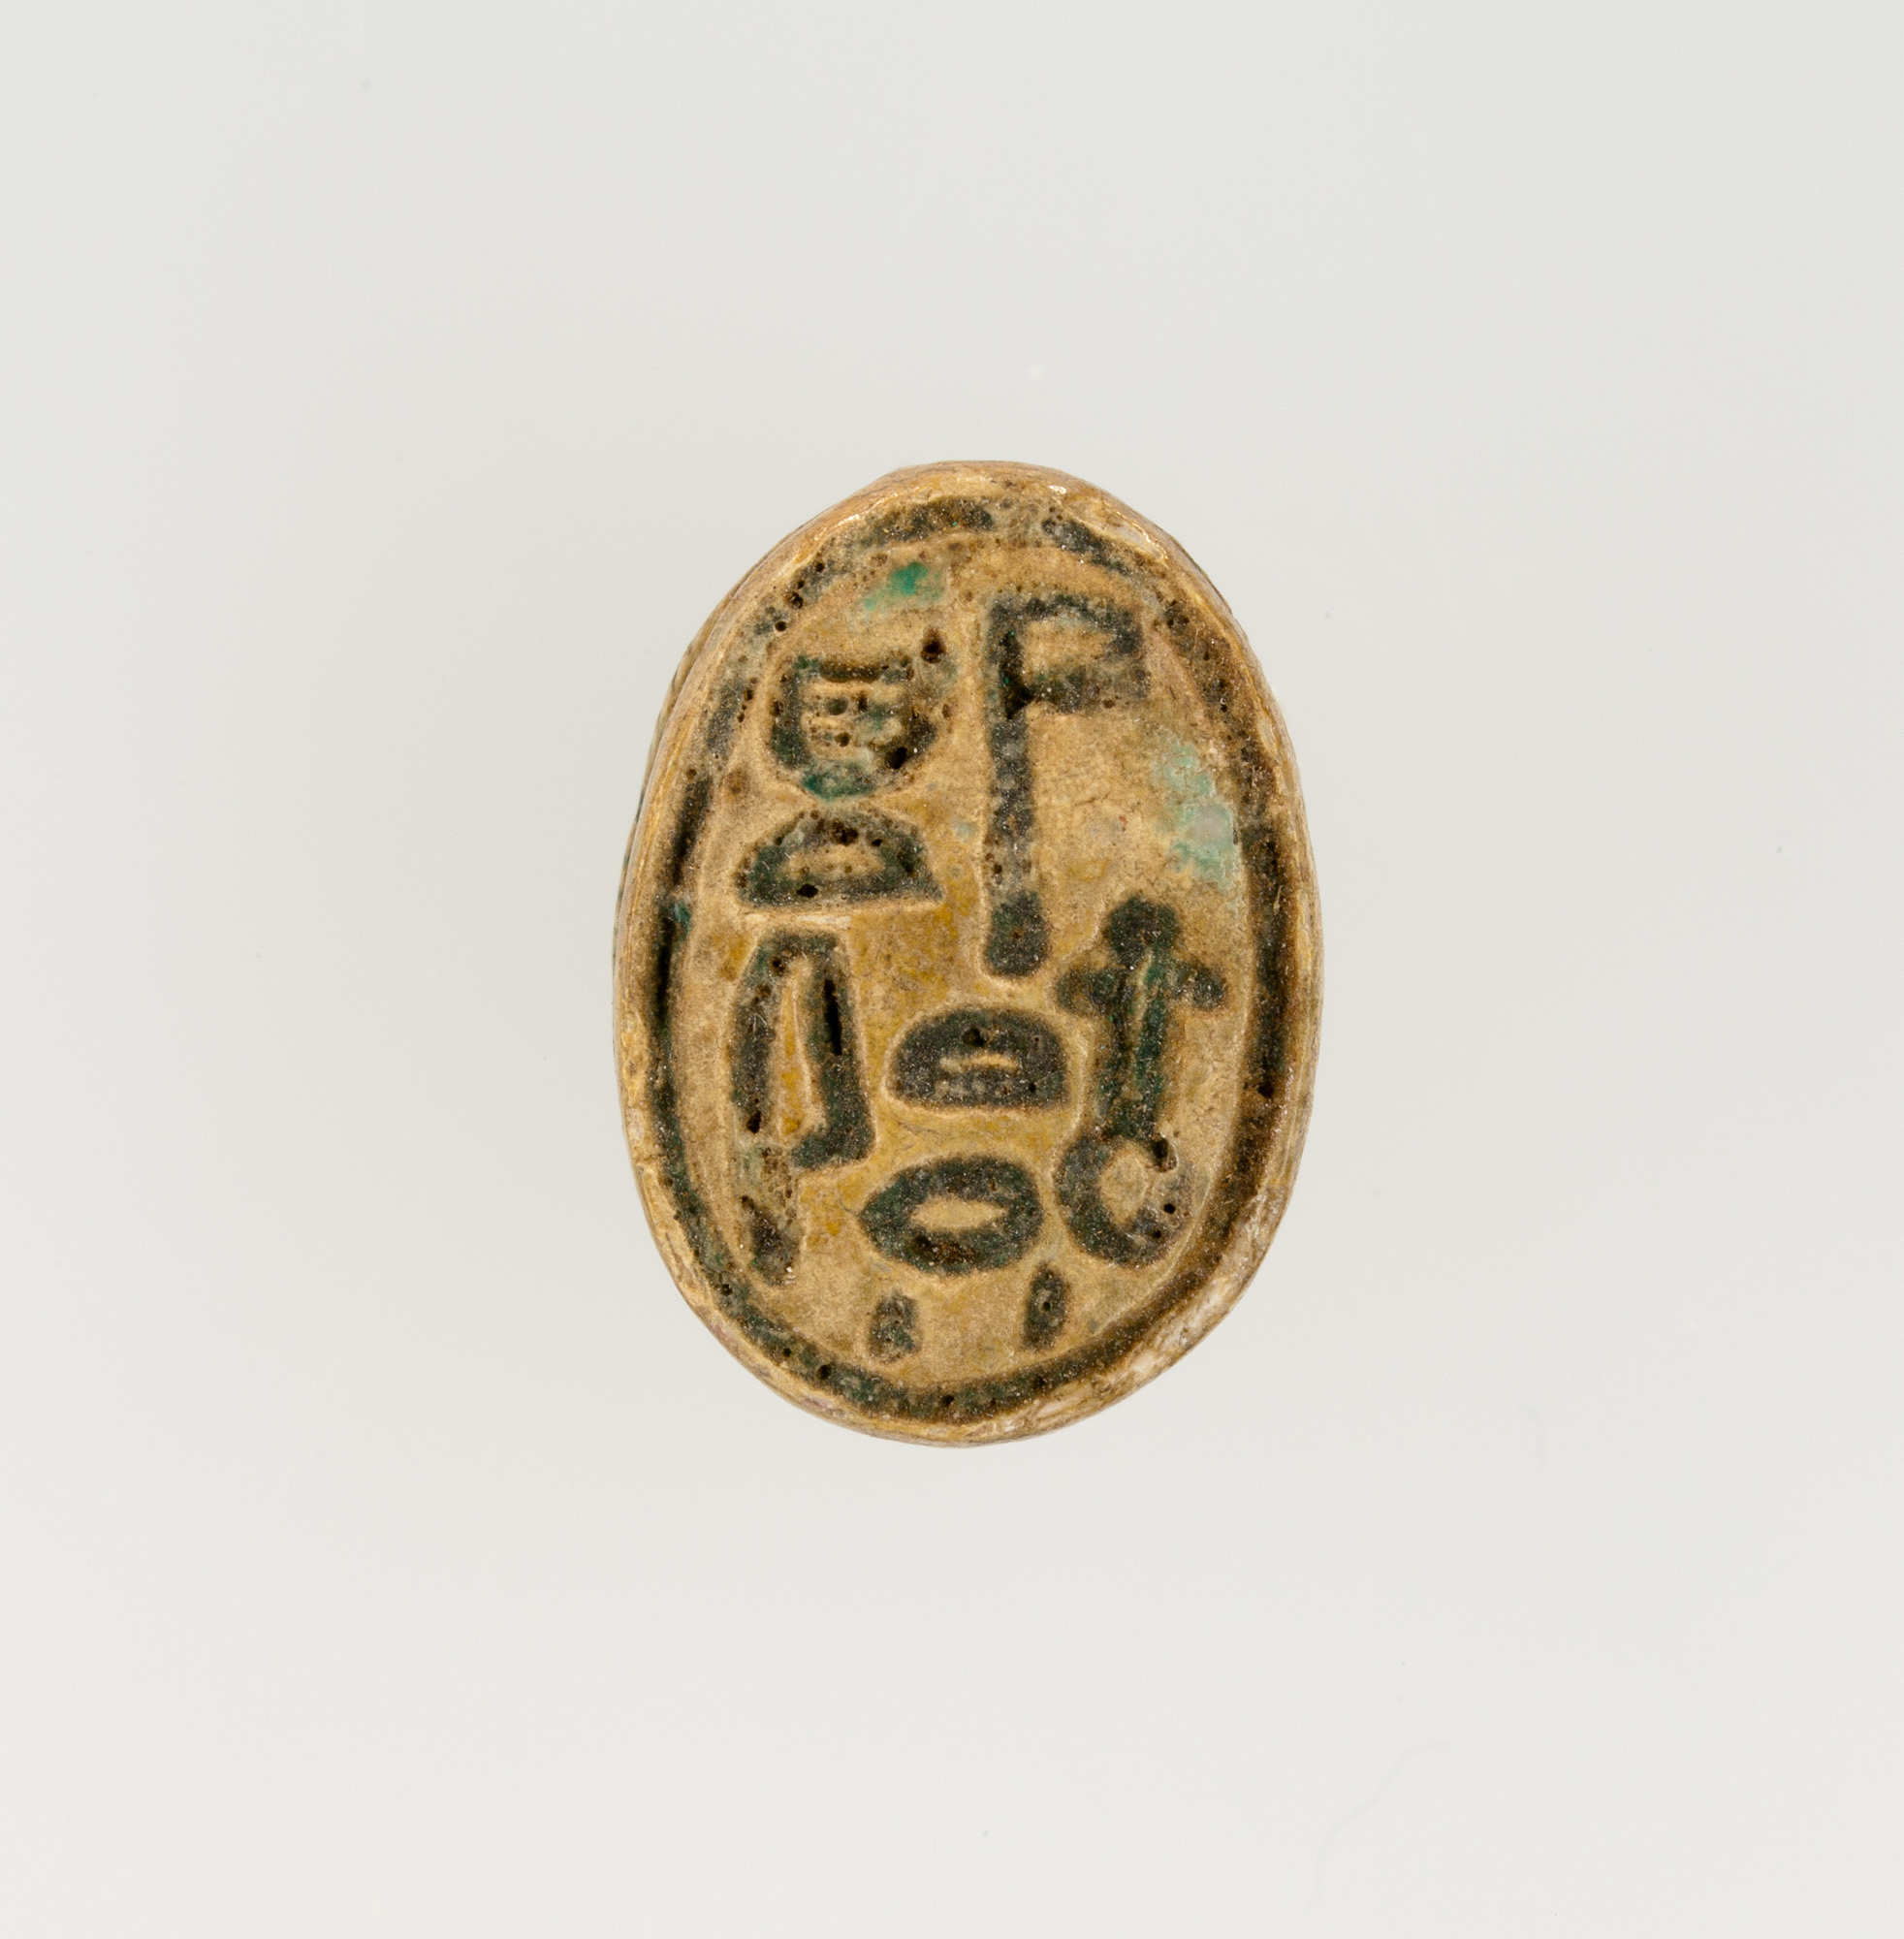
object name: scarab, ahmose nefertari, god's wife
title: Scarab Inscribed for the God's Wife (Ahmose-)Nefertari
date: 1550-1525 BCE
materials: stone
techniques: glazing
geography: egypt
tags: hieroglyphs,scarabs